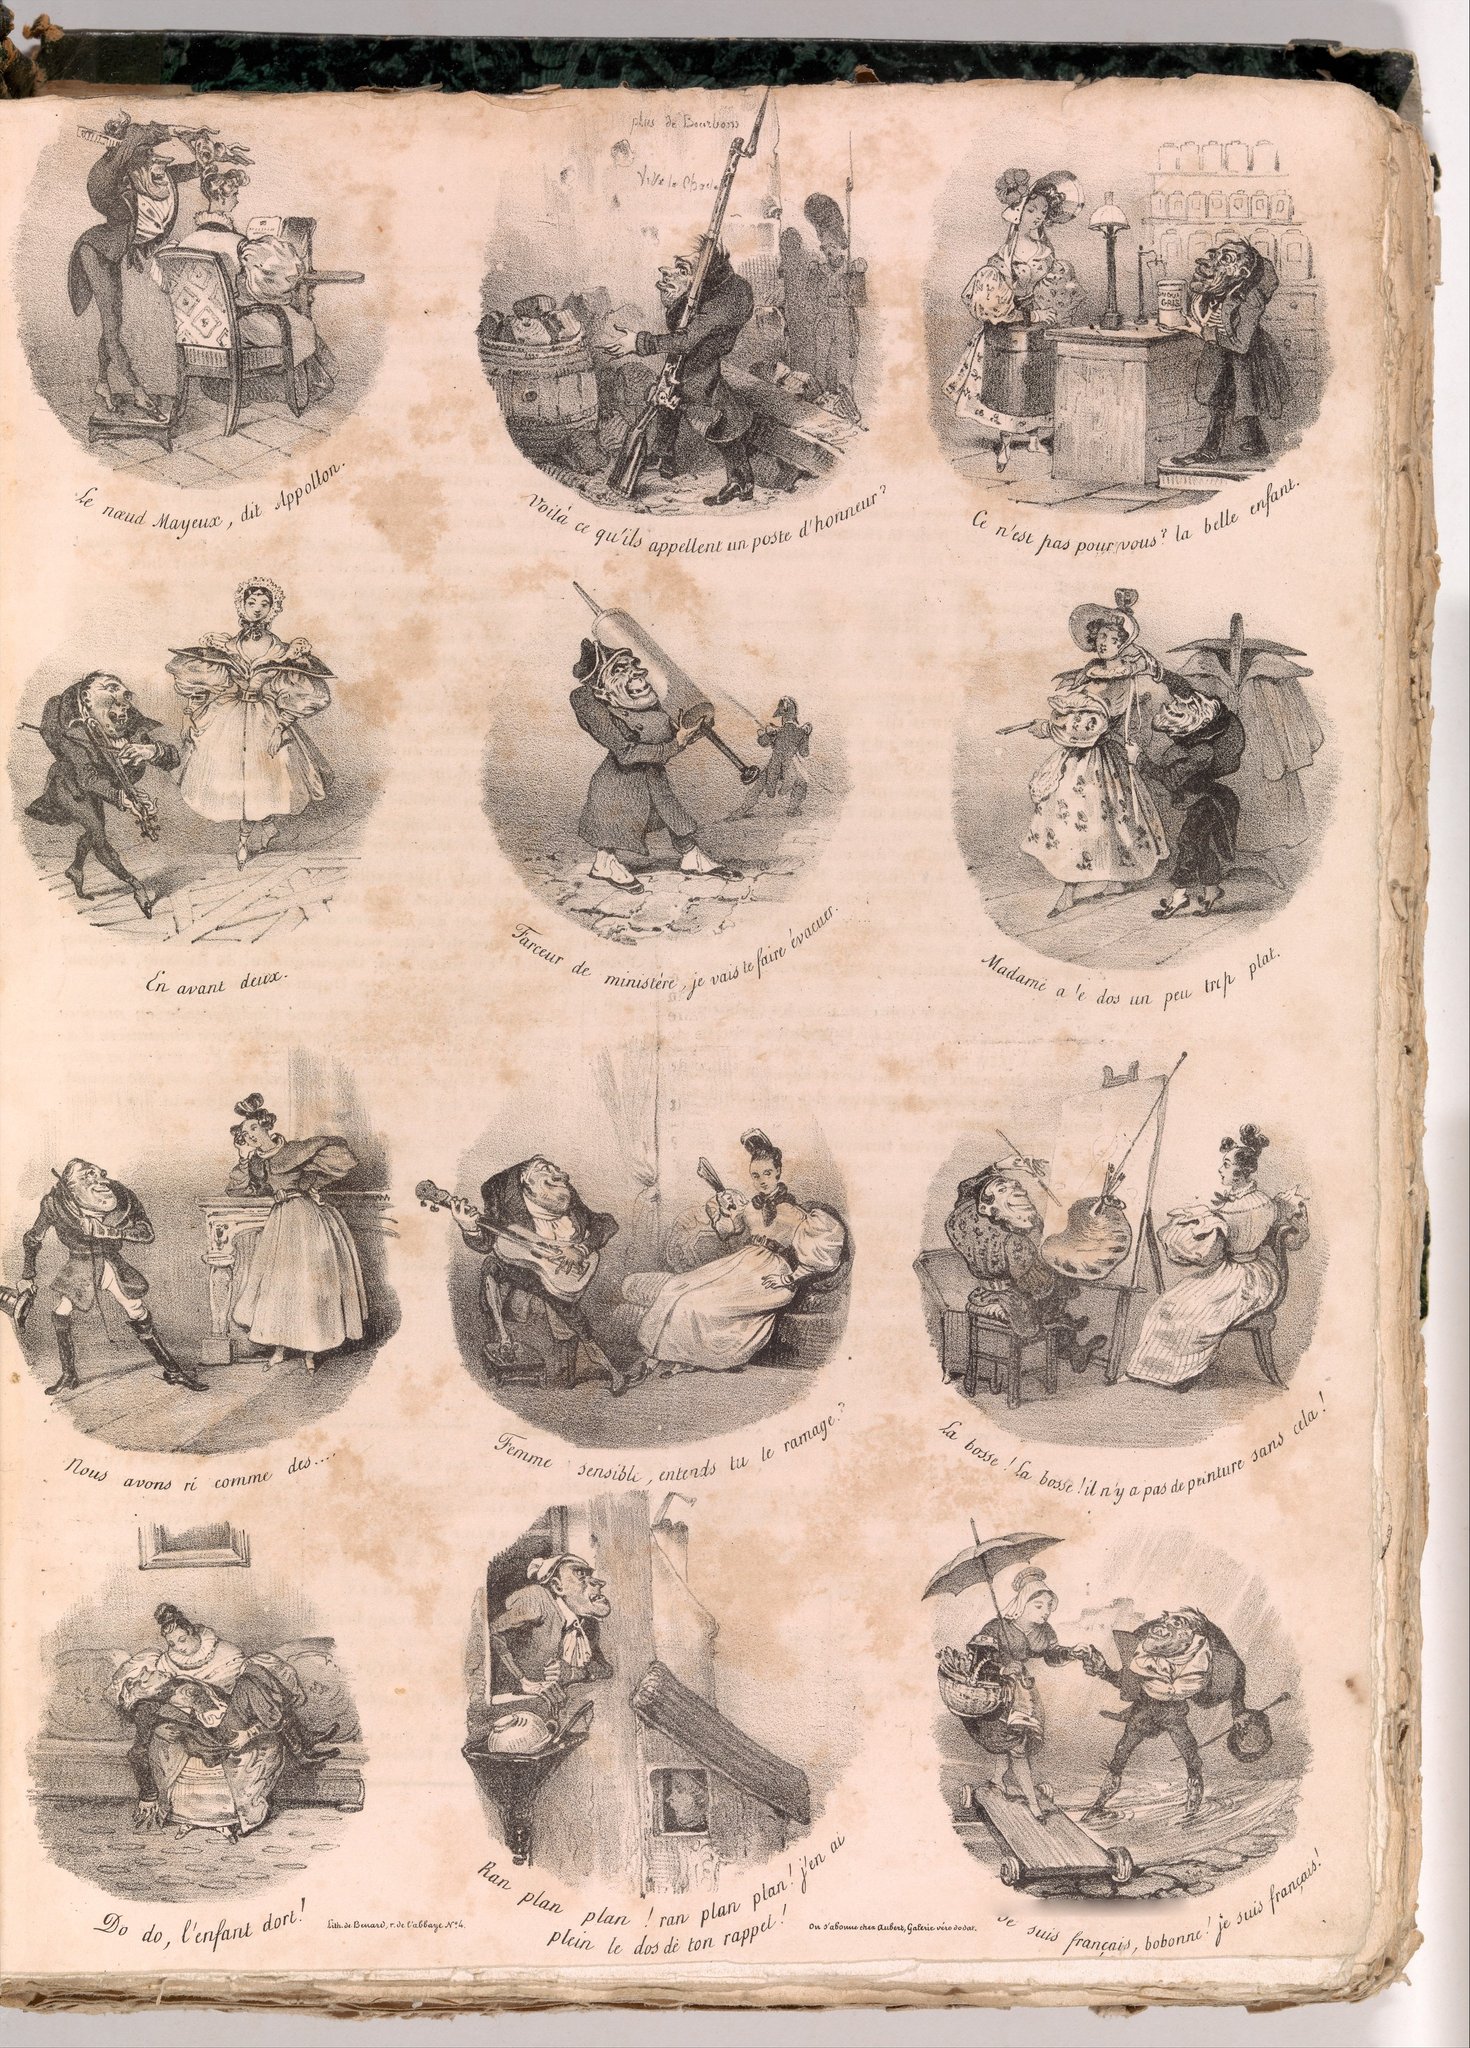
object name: print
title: Twelve Satirical Vignettes (Le Charivari, December 10, 1832)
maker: charles-joseph traviès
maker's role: artist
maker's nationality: french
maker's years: 1804-1859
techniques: lithograph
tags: satire,men,women,musicians